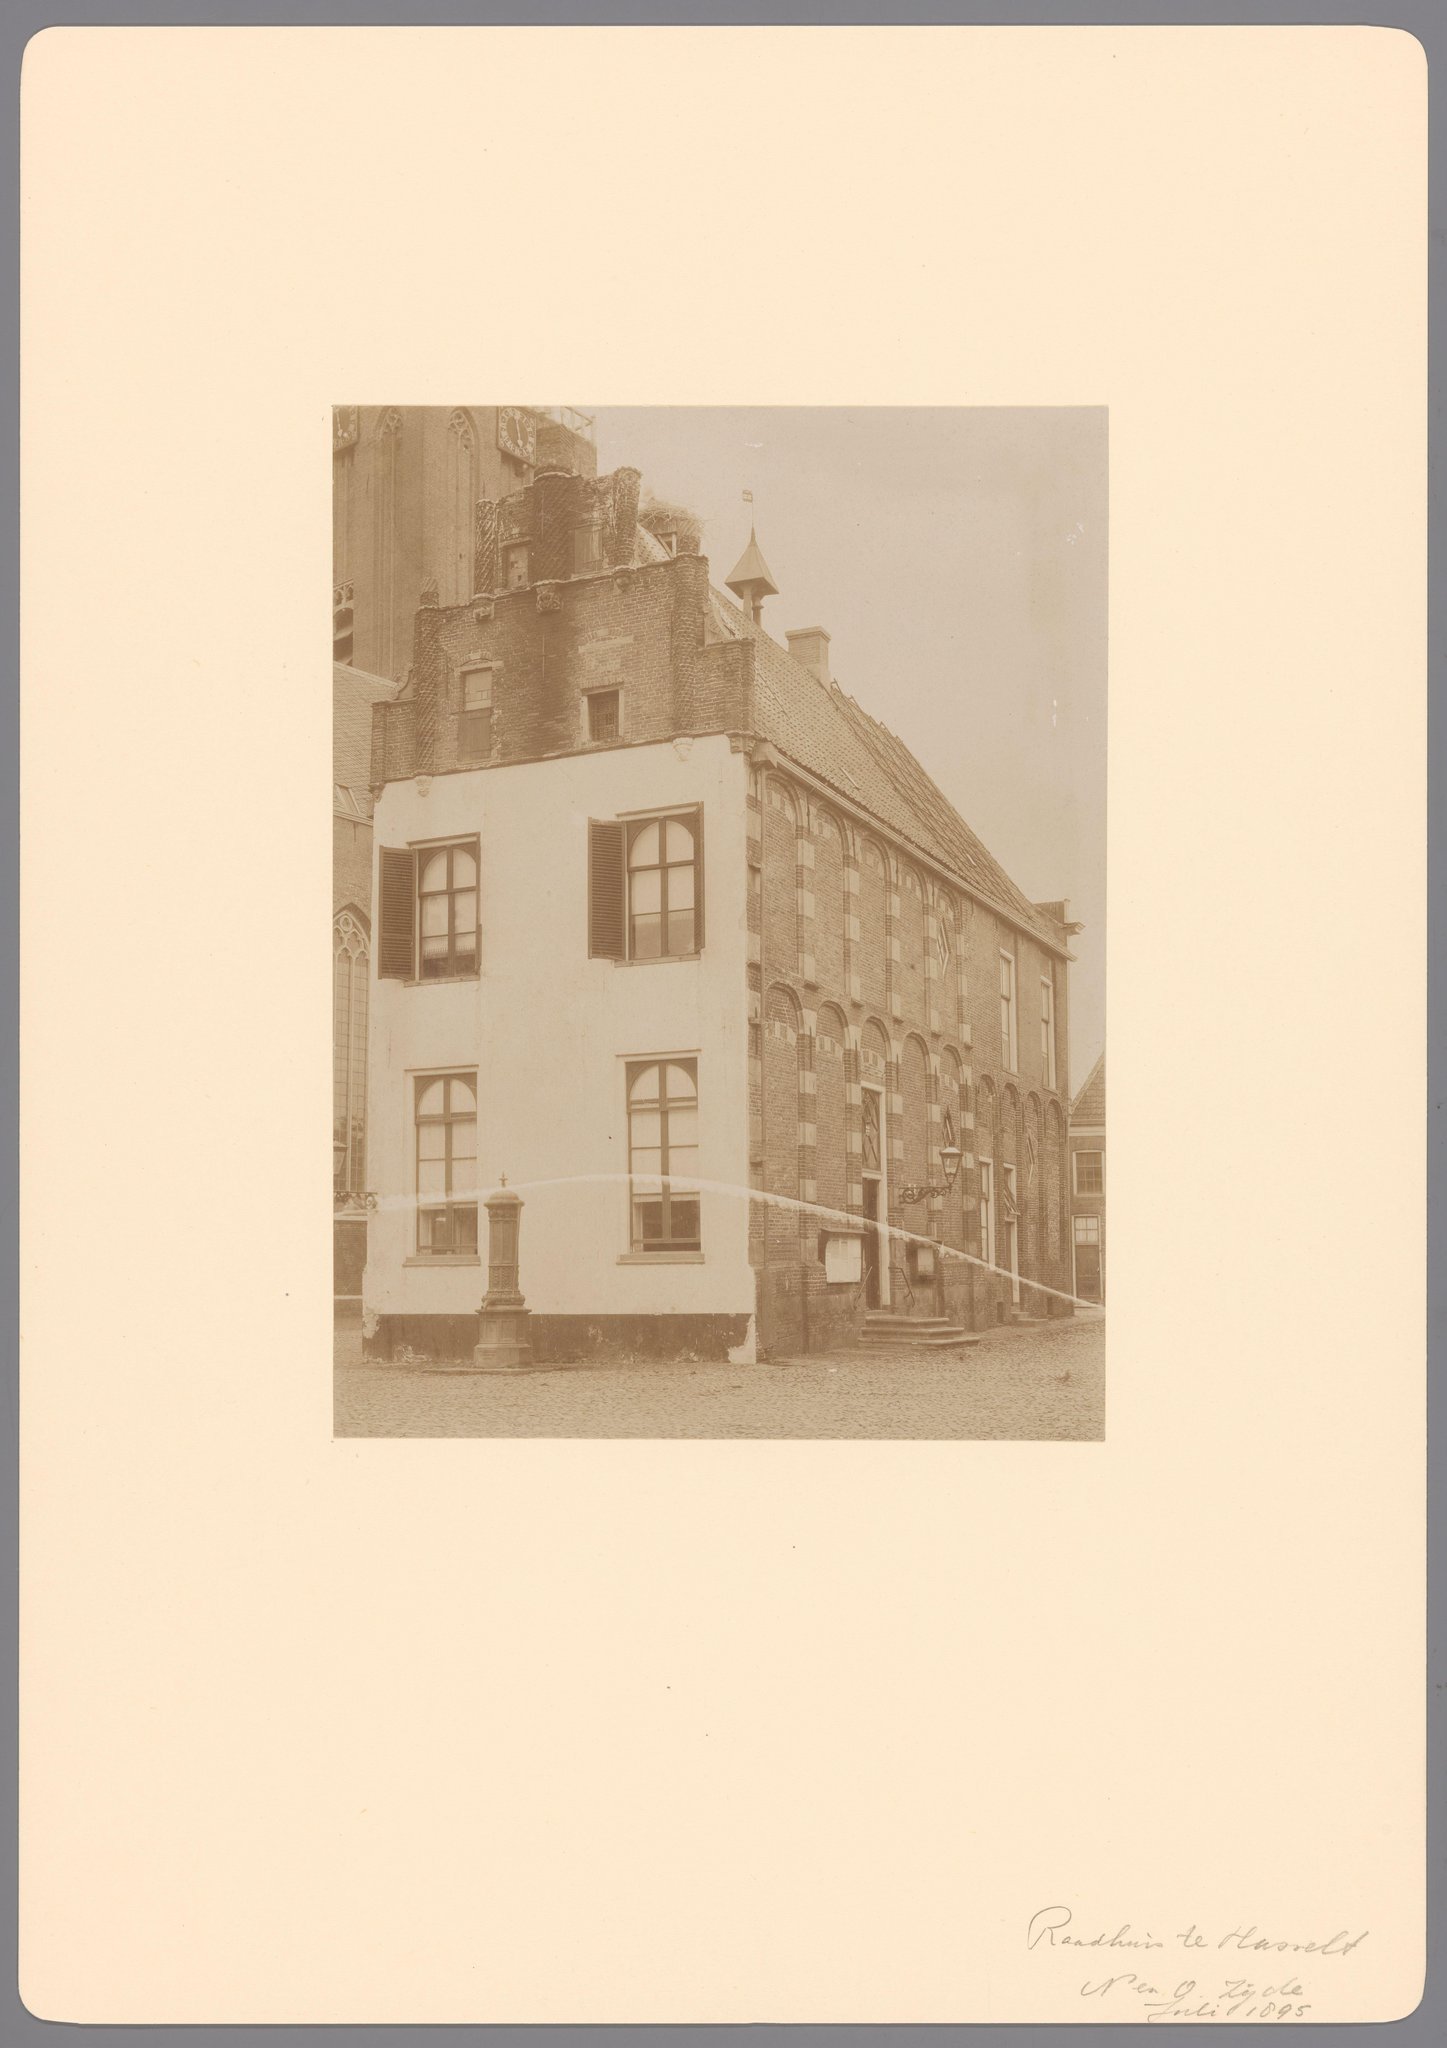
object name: photograph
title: Stadhuis te Hasselt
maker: anoniem (monumentenzorg)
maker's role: fotograaf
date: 1895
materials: cardboard, photographic support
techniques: collodion silver print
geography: hasselt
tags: townhall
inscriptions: annotation: ‘Raadhuis te Hasselt/ N en O. Zijde/ juli 1895’